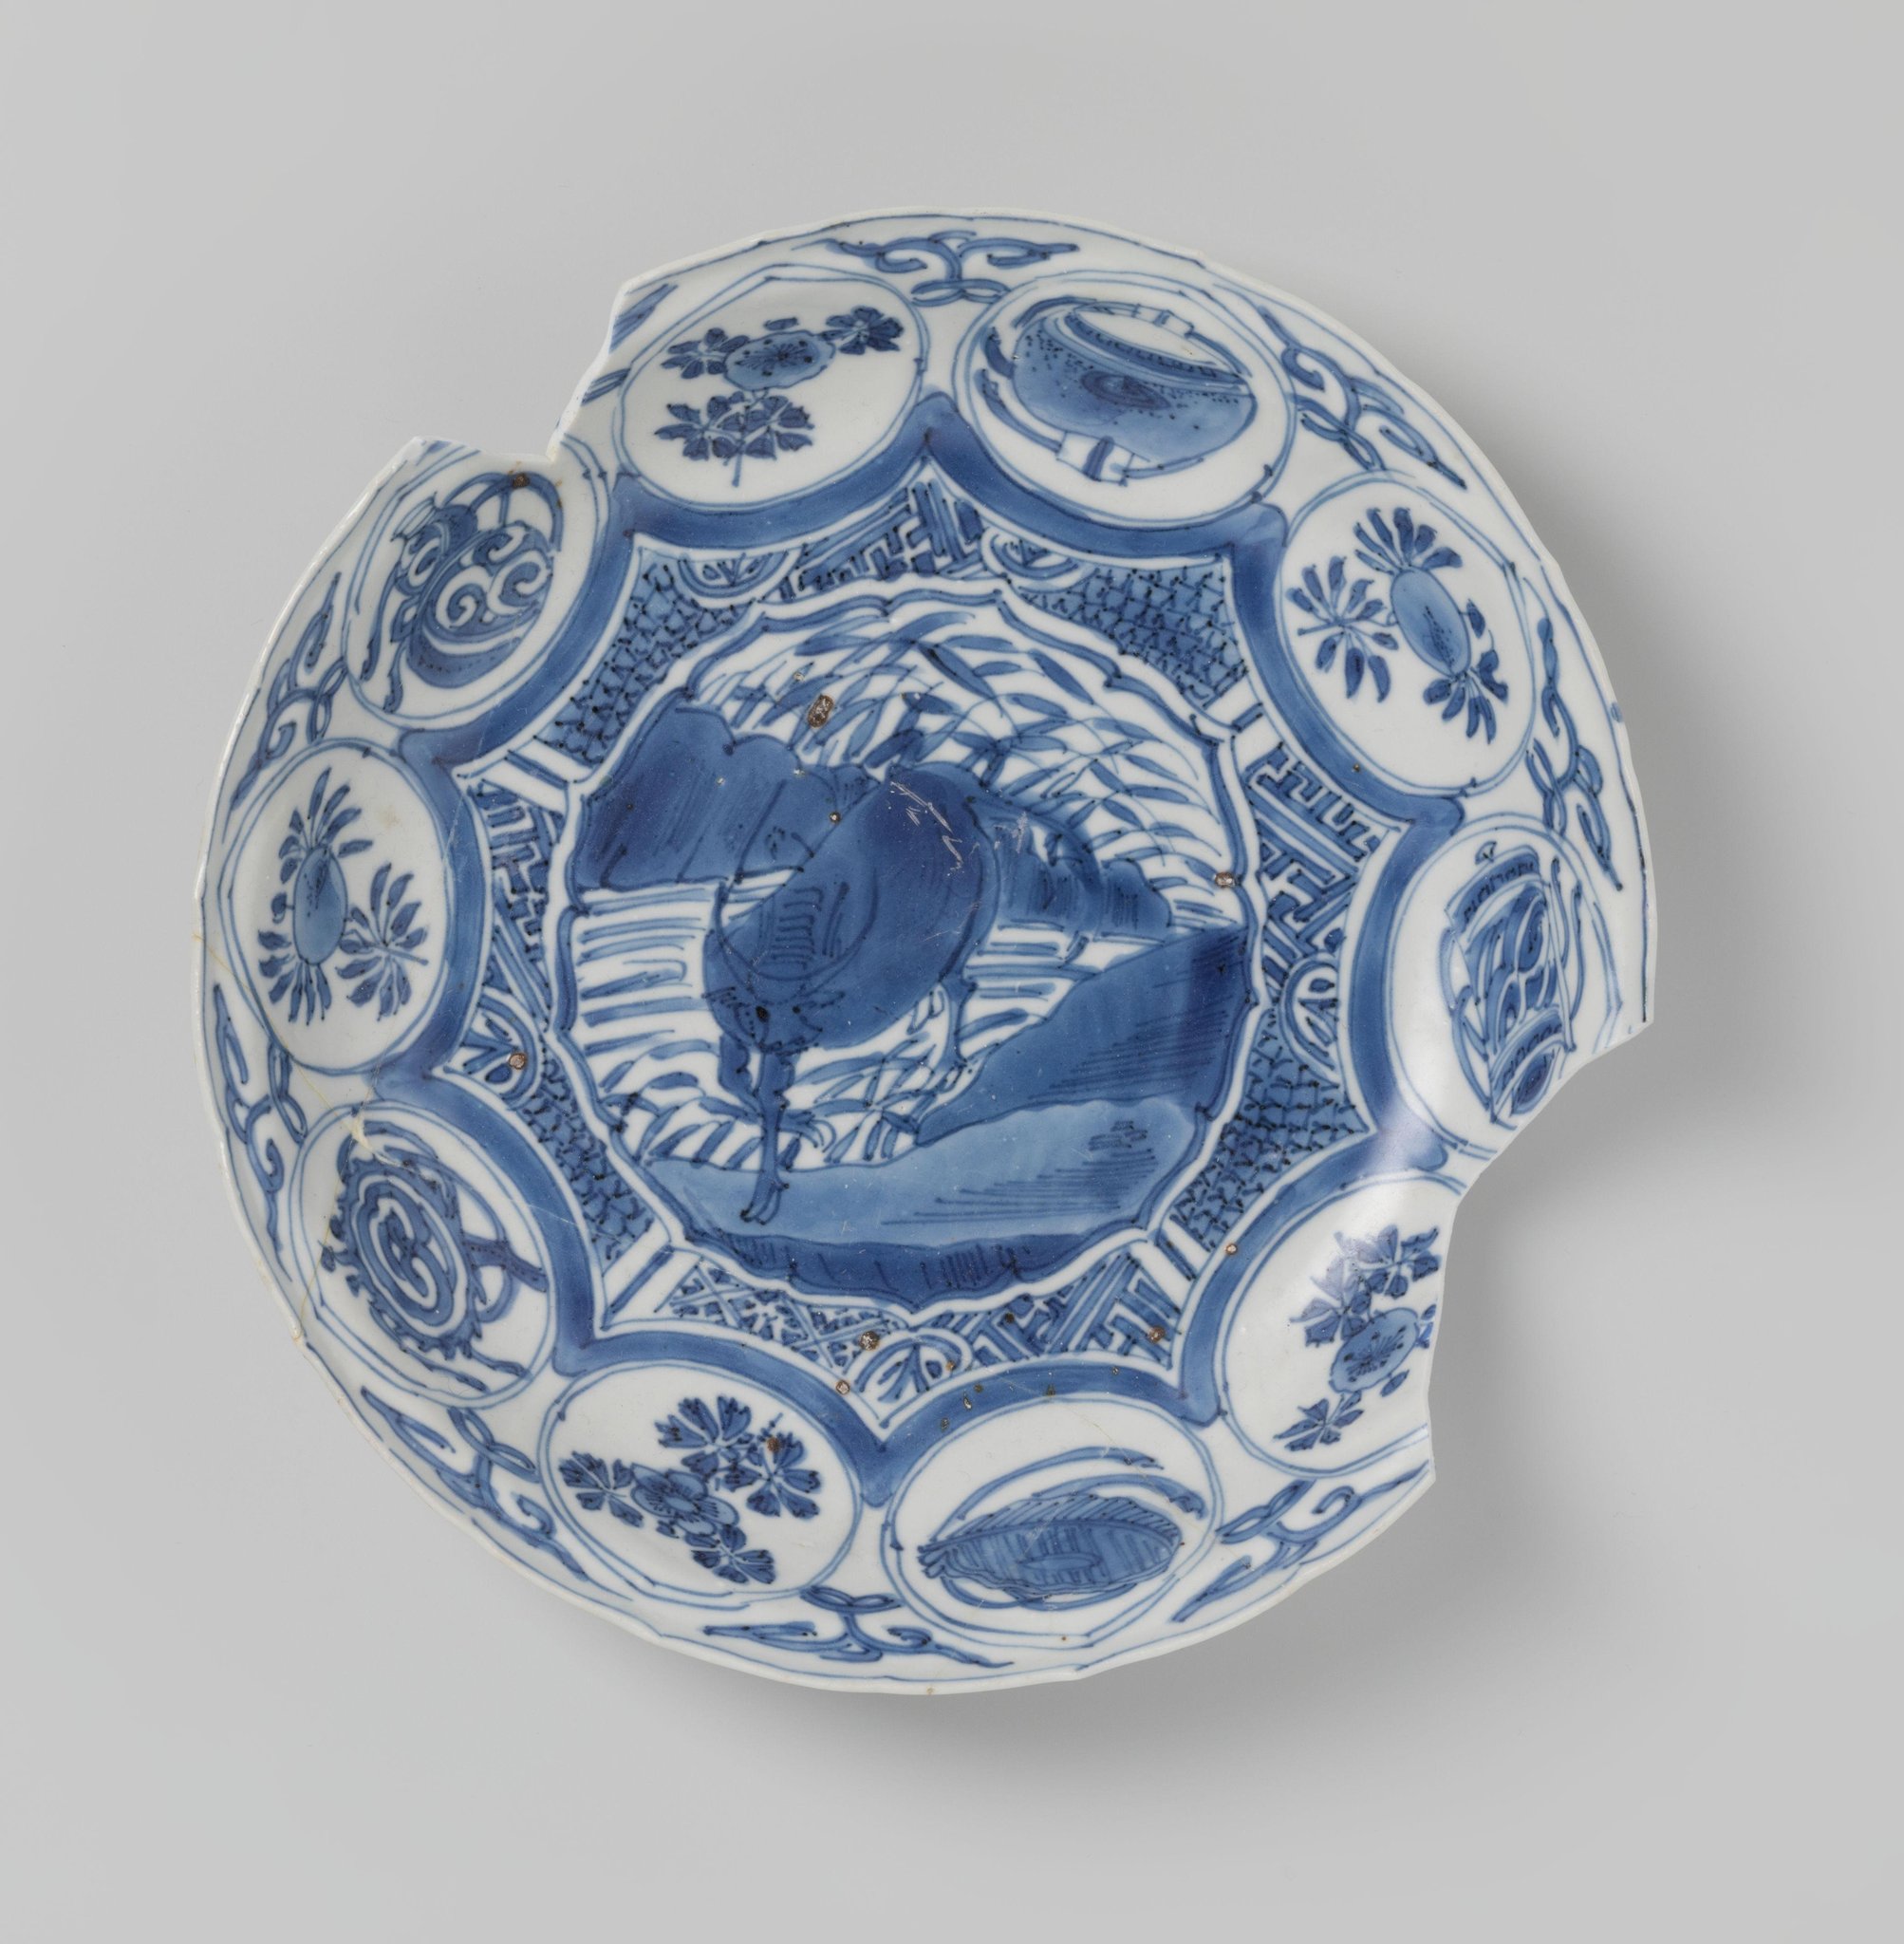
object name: plate dish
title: Bord uit V.O.C.-schip de 'Witte Leeuw'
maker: Anonymous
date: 1613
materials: bone china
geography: jingdezhen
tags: verenigde oostindische compagnie, sint-helena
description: A dish without a flattened rim. A scalloped medallion with rui heads alternating with radial panels within a star-shaped medallion, filled with various diaper patterns. A central decoration of a waterbuffalo on a bank The medallions decorated with alternately a flower or fruit and a symbol.